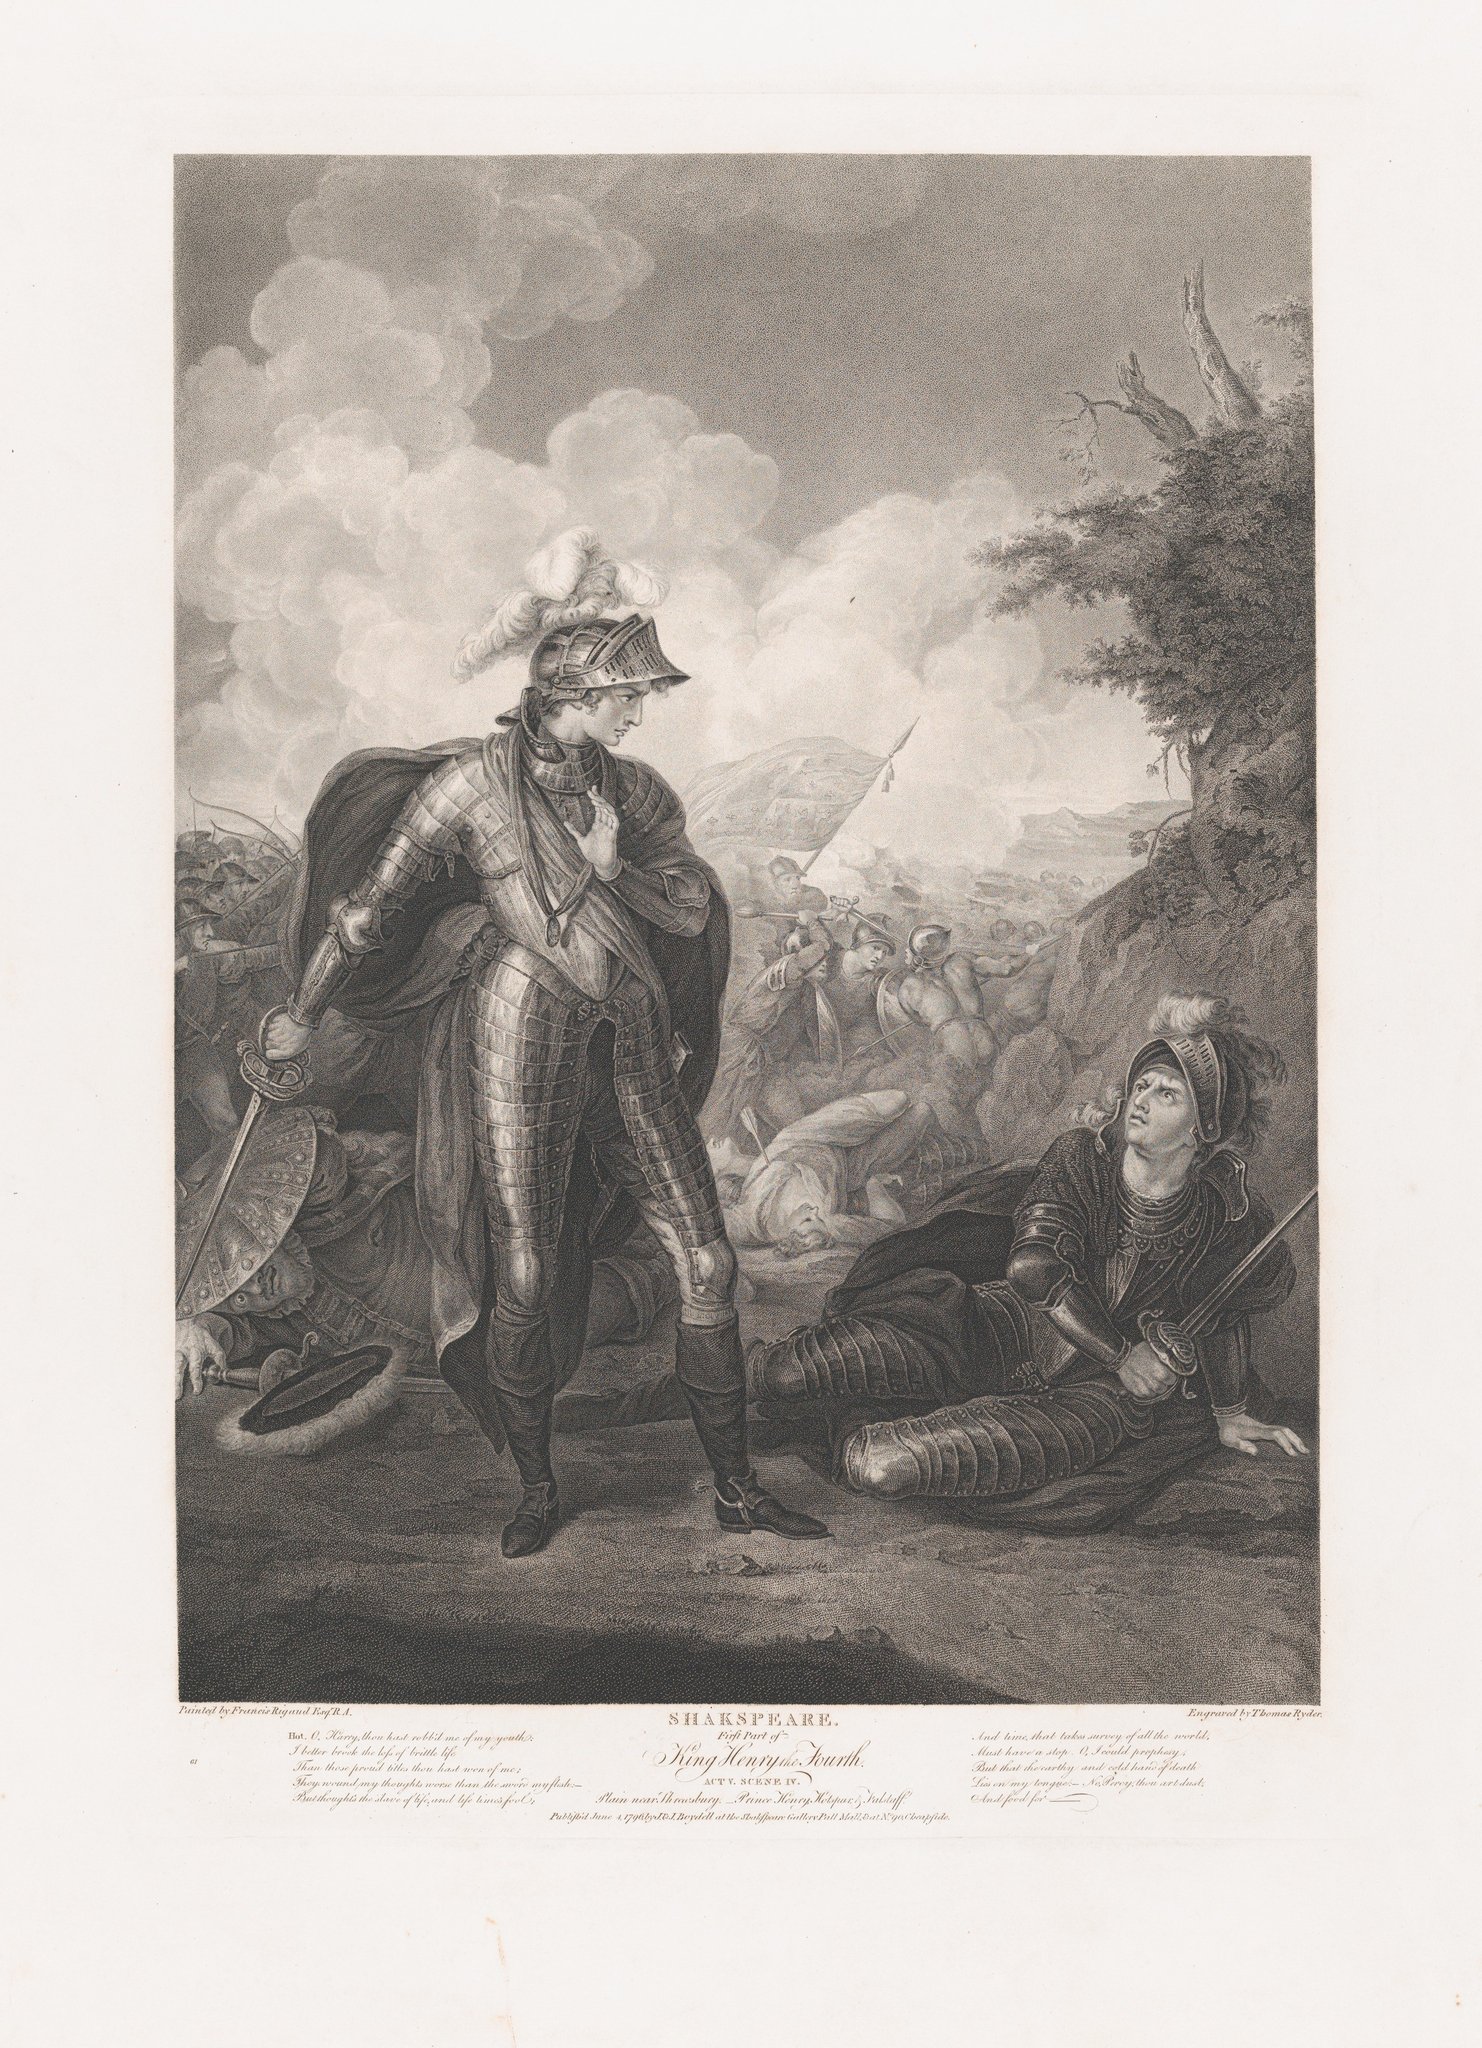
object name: print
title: Prince Henry, Hotspur and Falstaff (Shakespeare, King Henry IV, Part 1, Act 5, Scene 4)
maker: thomas ryder i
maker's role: engraver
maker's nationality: british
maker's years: 1746-1810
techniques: engraving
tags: princes,shakespeare,men